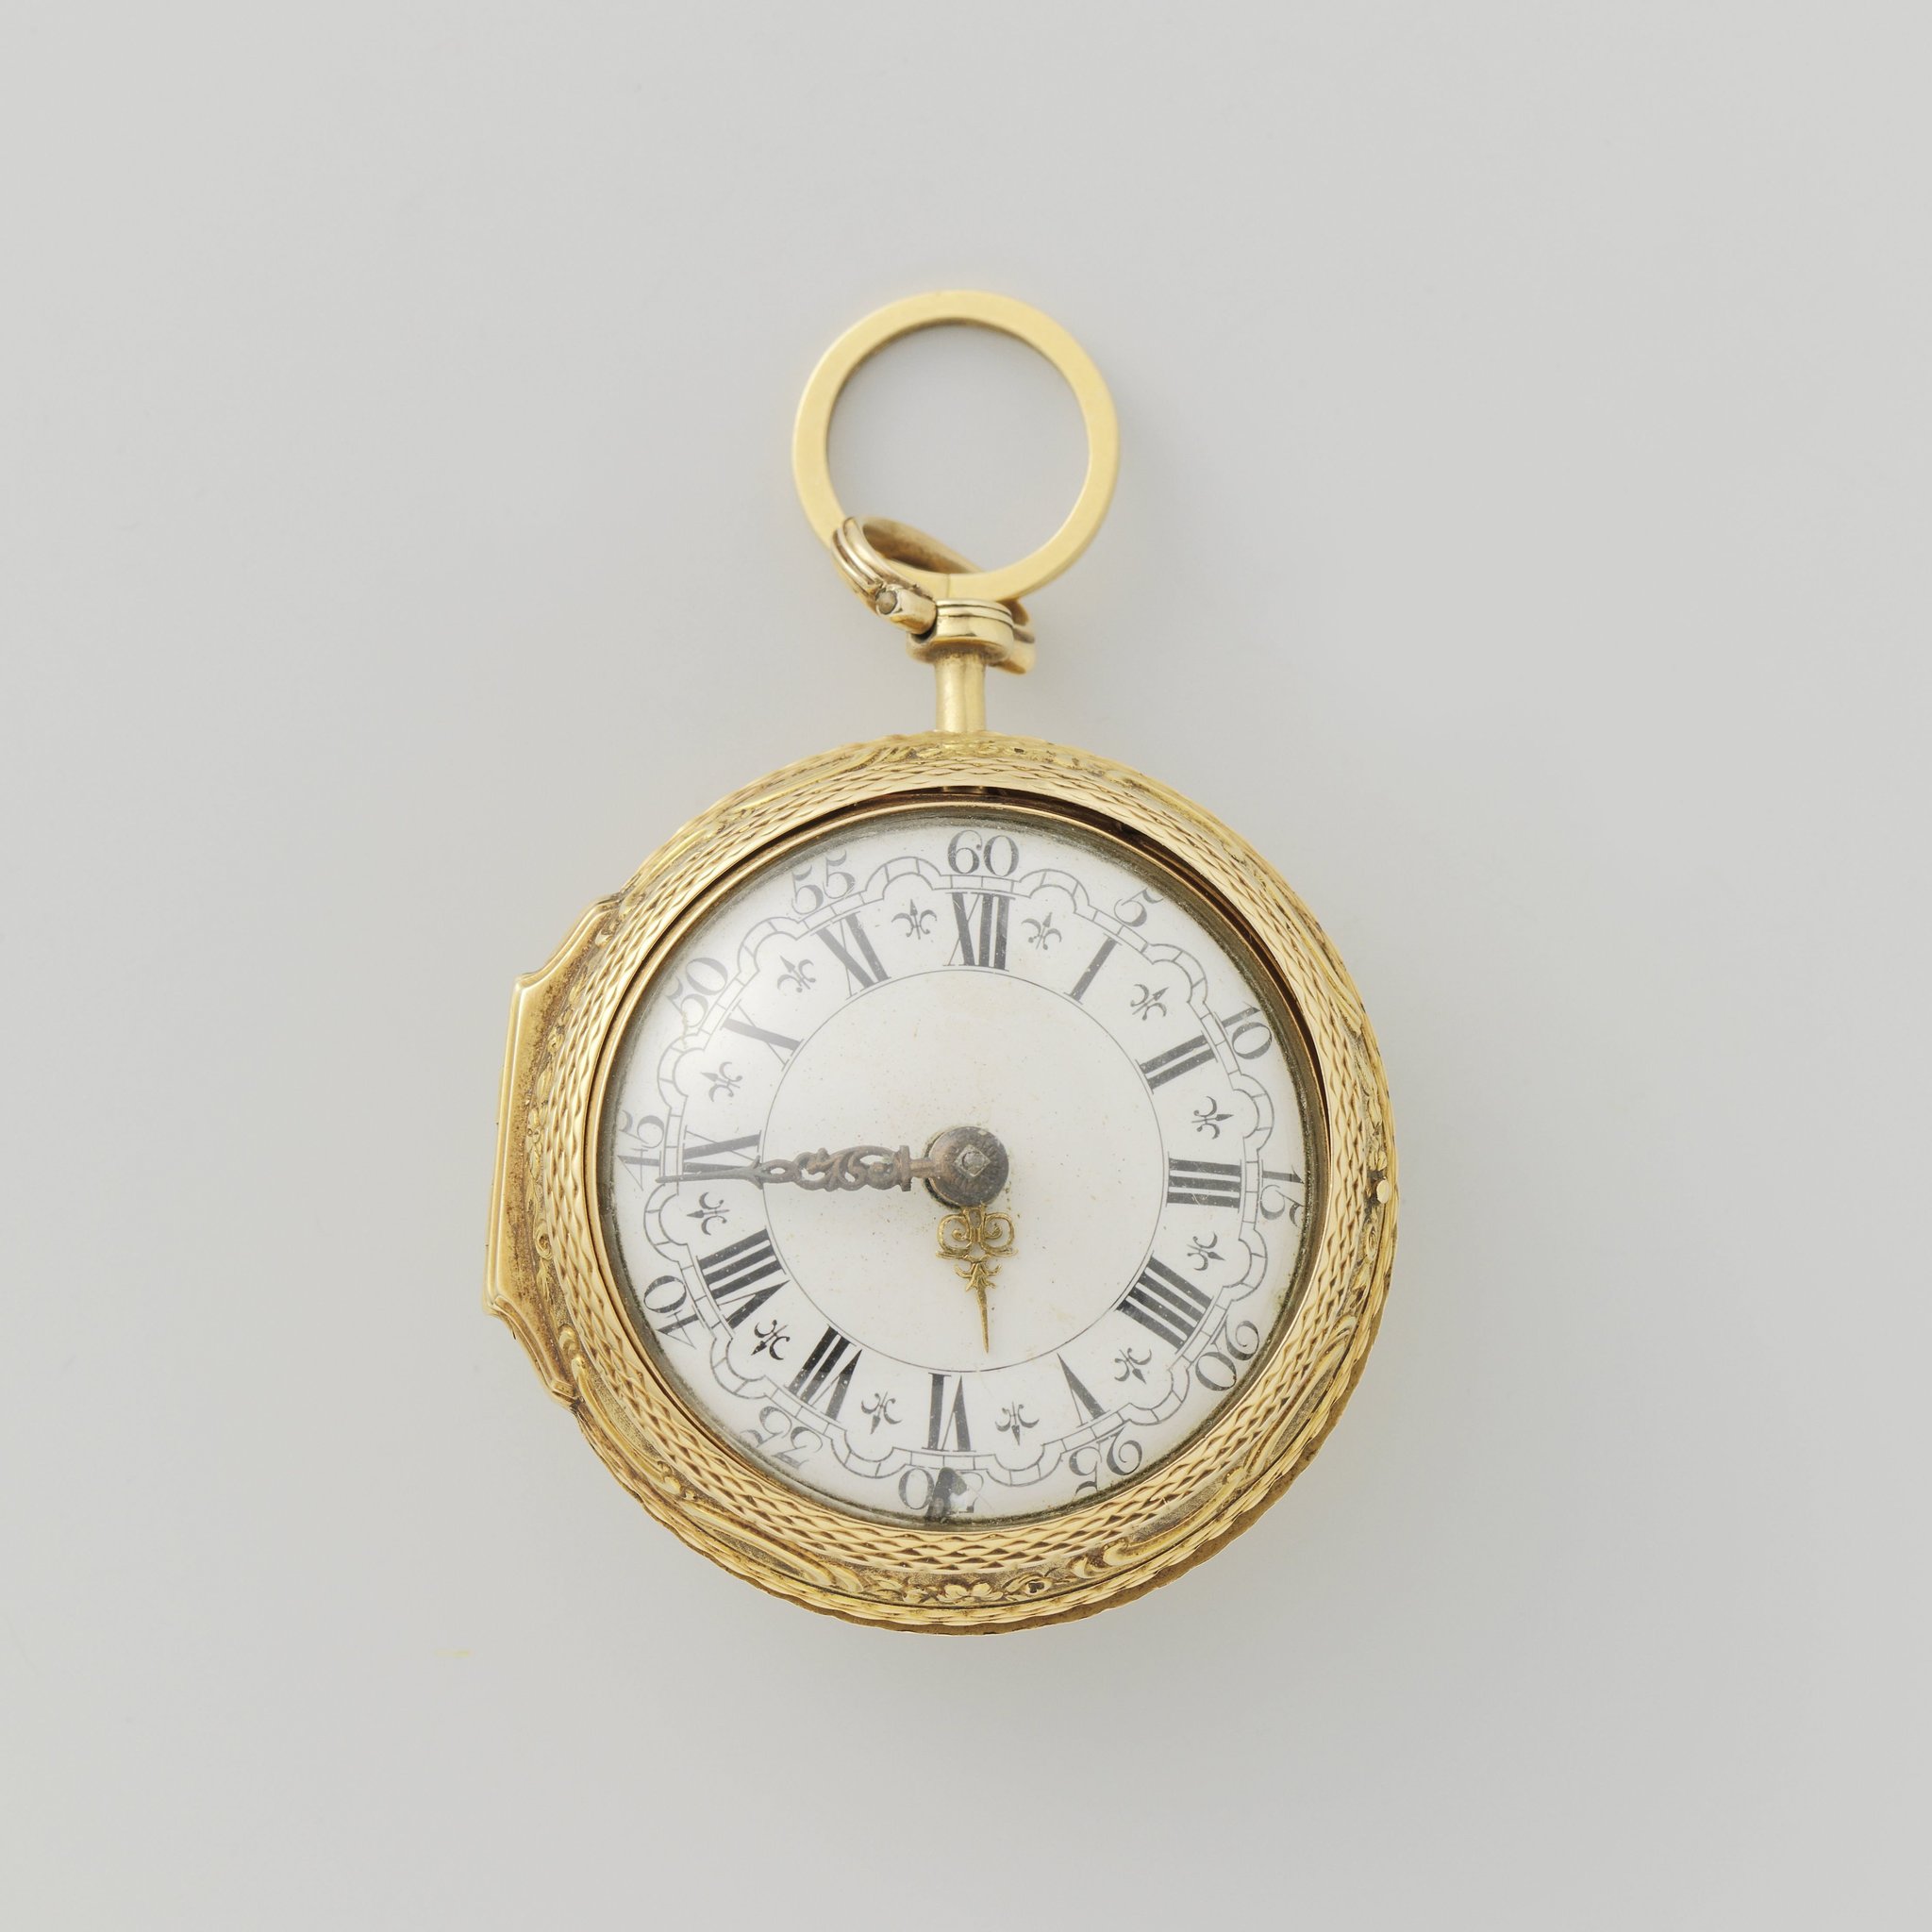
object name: jewellery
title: Watch with Hector's Farewell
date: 1761-1762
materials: gold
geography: london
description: Gouden horloge met gegraveerde en geciseleerde gouden kast. De buitenkast is versierd met een gedreven en geciseleerde voorstelling van Hector's afscheid.